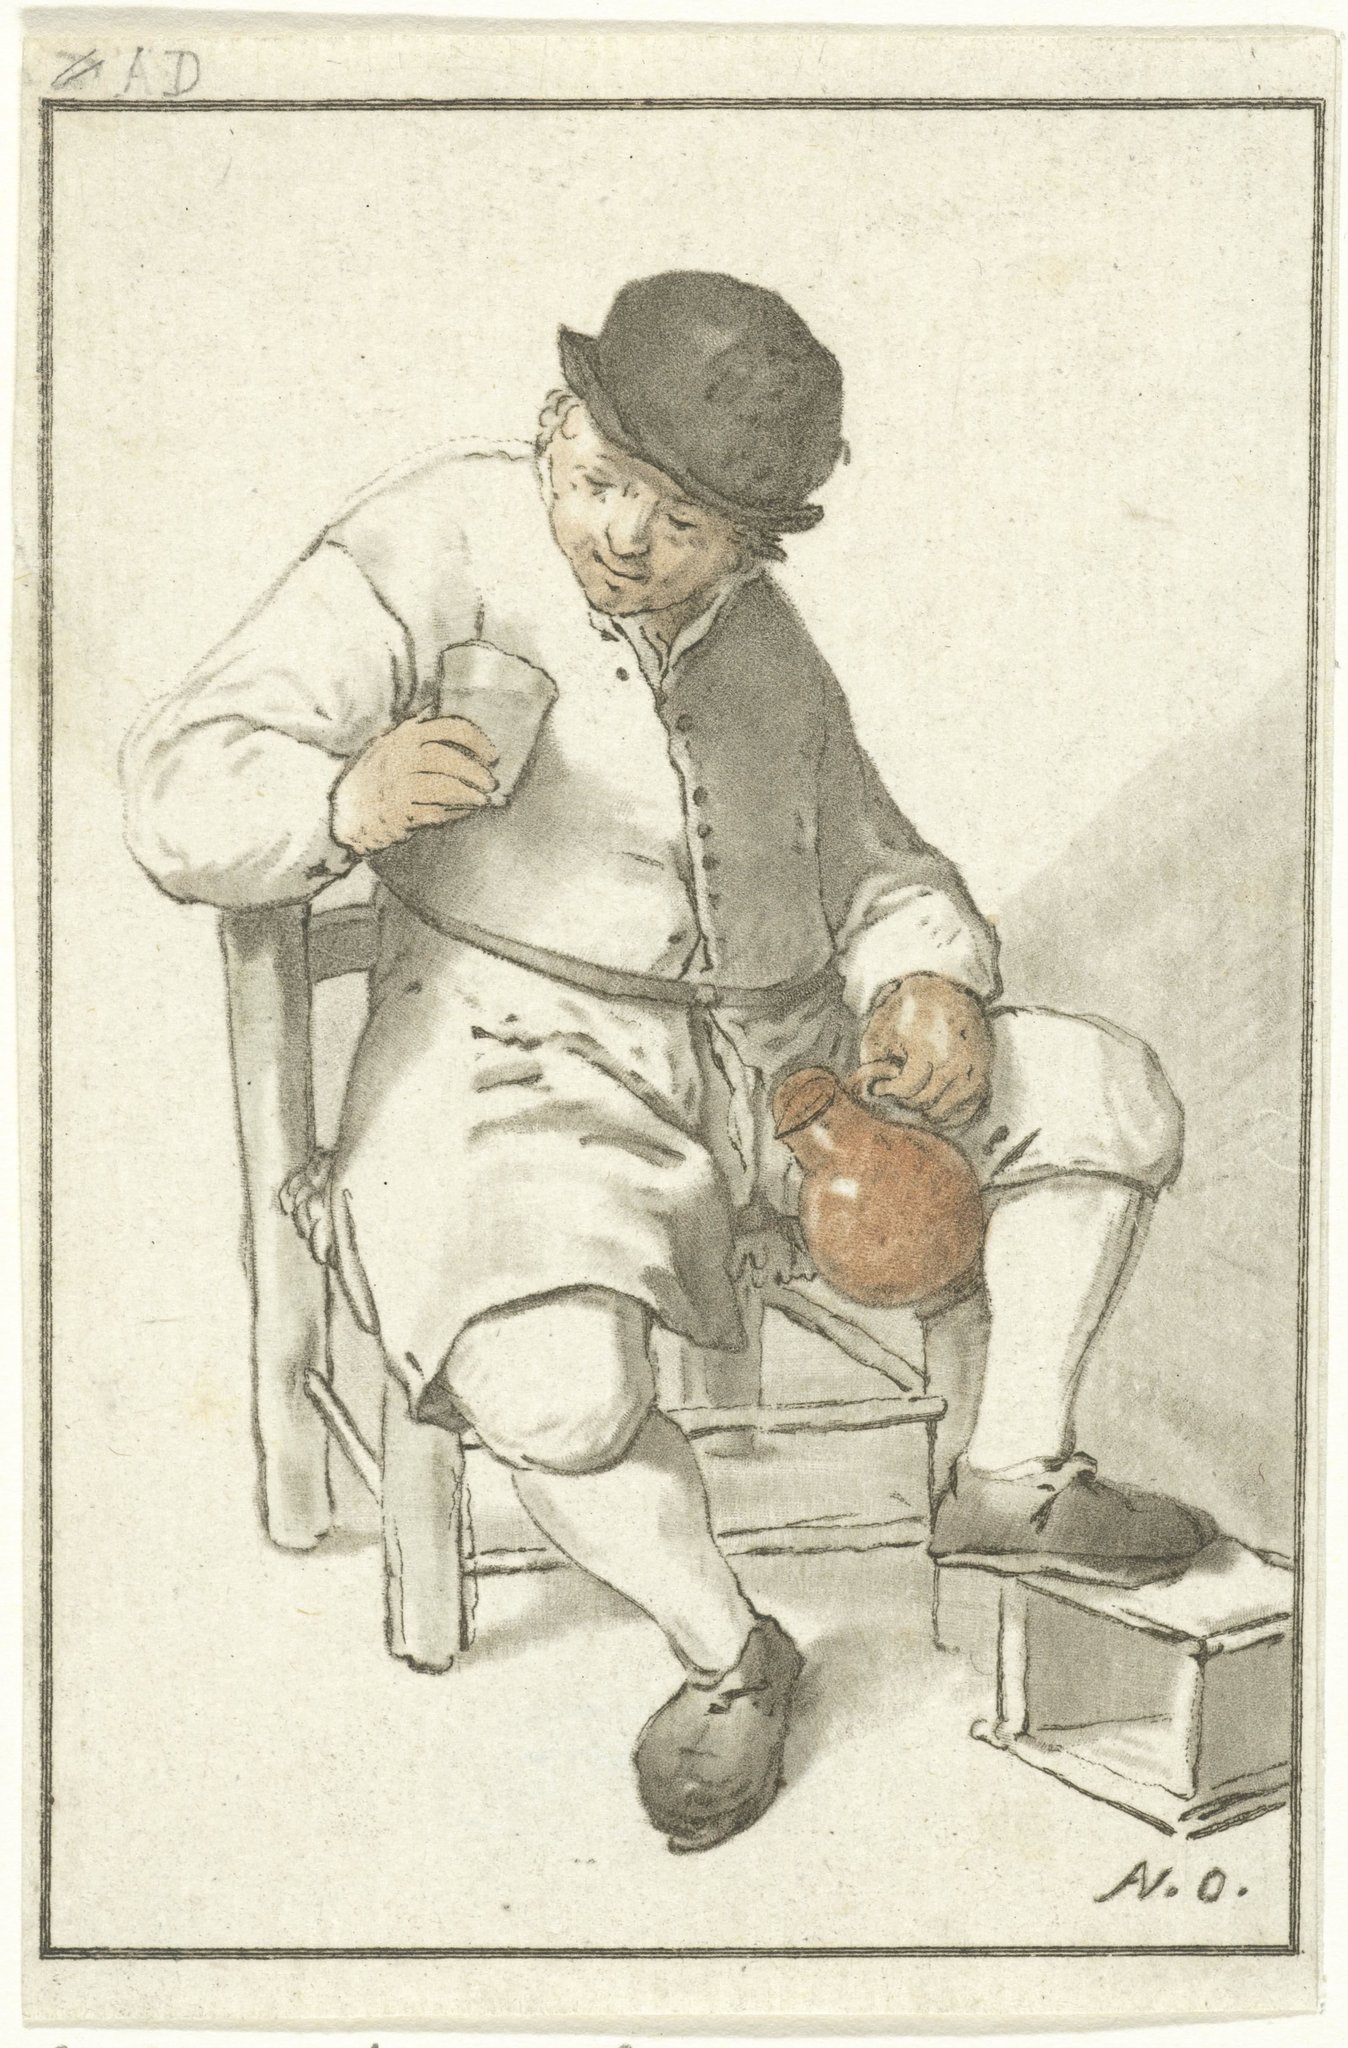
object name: print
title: Zittende boer met kruik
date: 1763-1768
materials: paper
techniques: roulette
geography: amsterdam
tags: sitting figure, jar, jug (used as drinking-vessel)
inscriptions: collector's mark: Lugt 2228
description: Voor deze prenttekening, 'Zittende boer met kruik', maakte Ploos van Amstel vier verschillende platen (A, B, C, en D). Er bestaan afdrukken van één, twee, drie of alle vier de platen in alle mogelijke combinaties. Zie gerelateerde objecten voor de hier gebruikte platen.